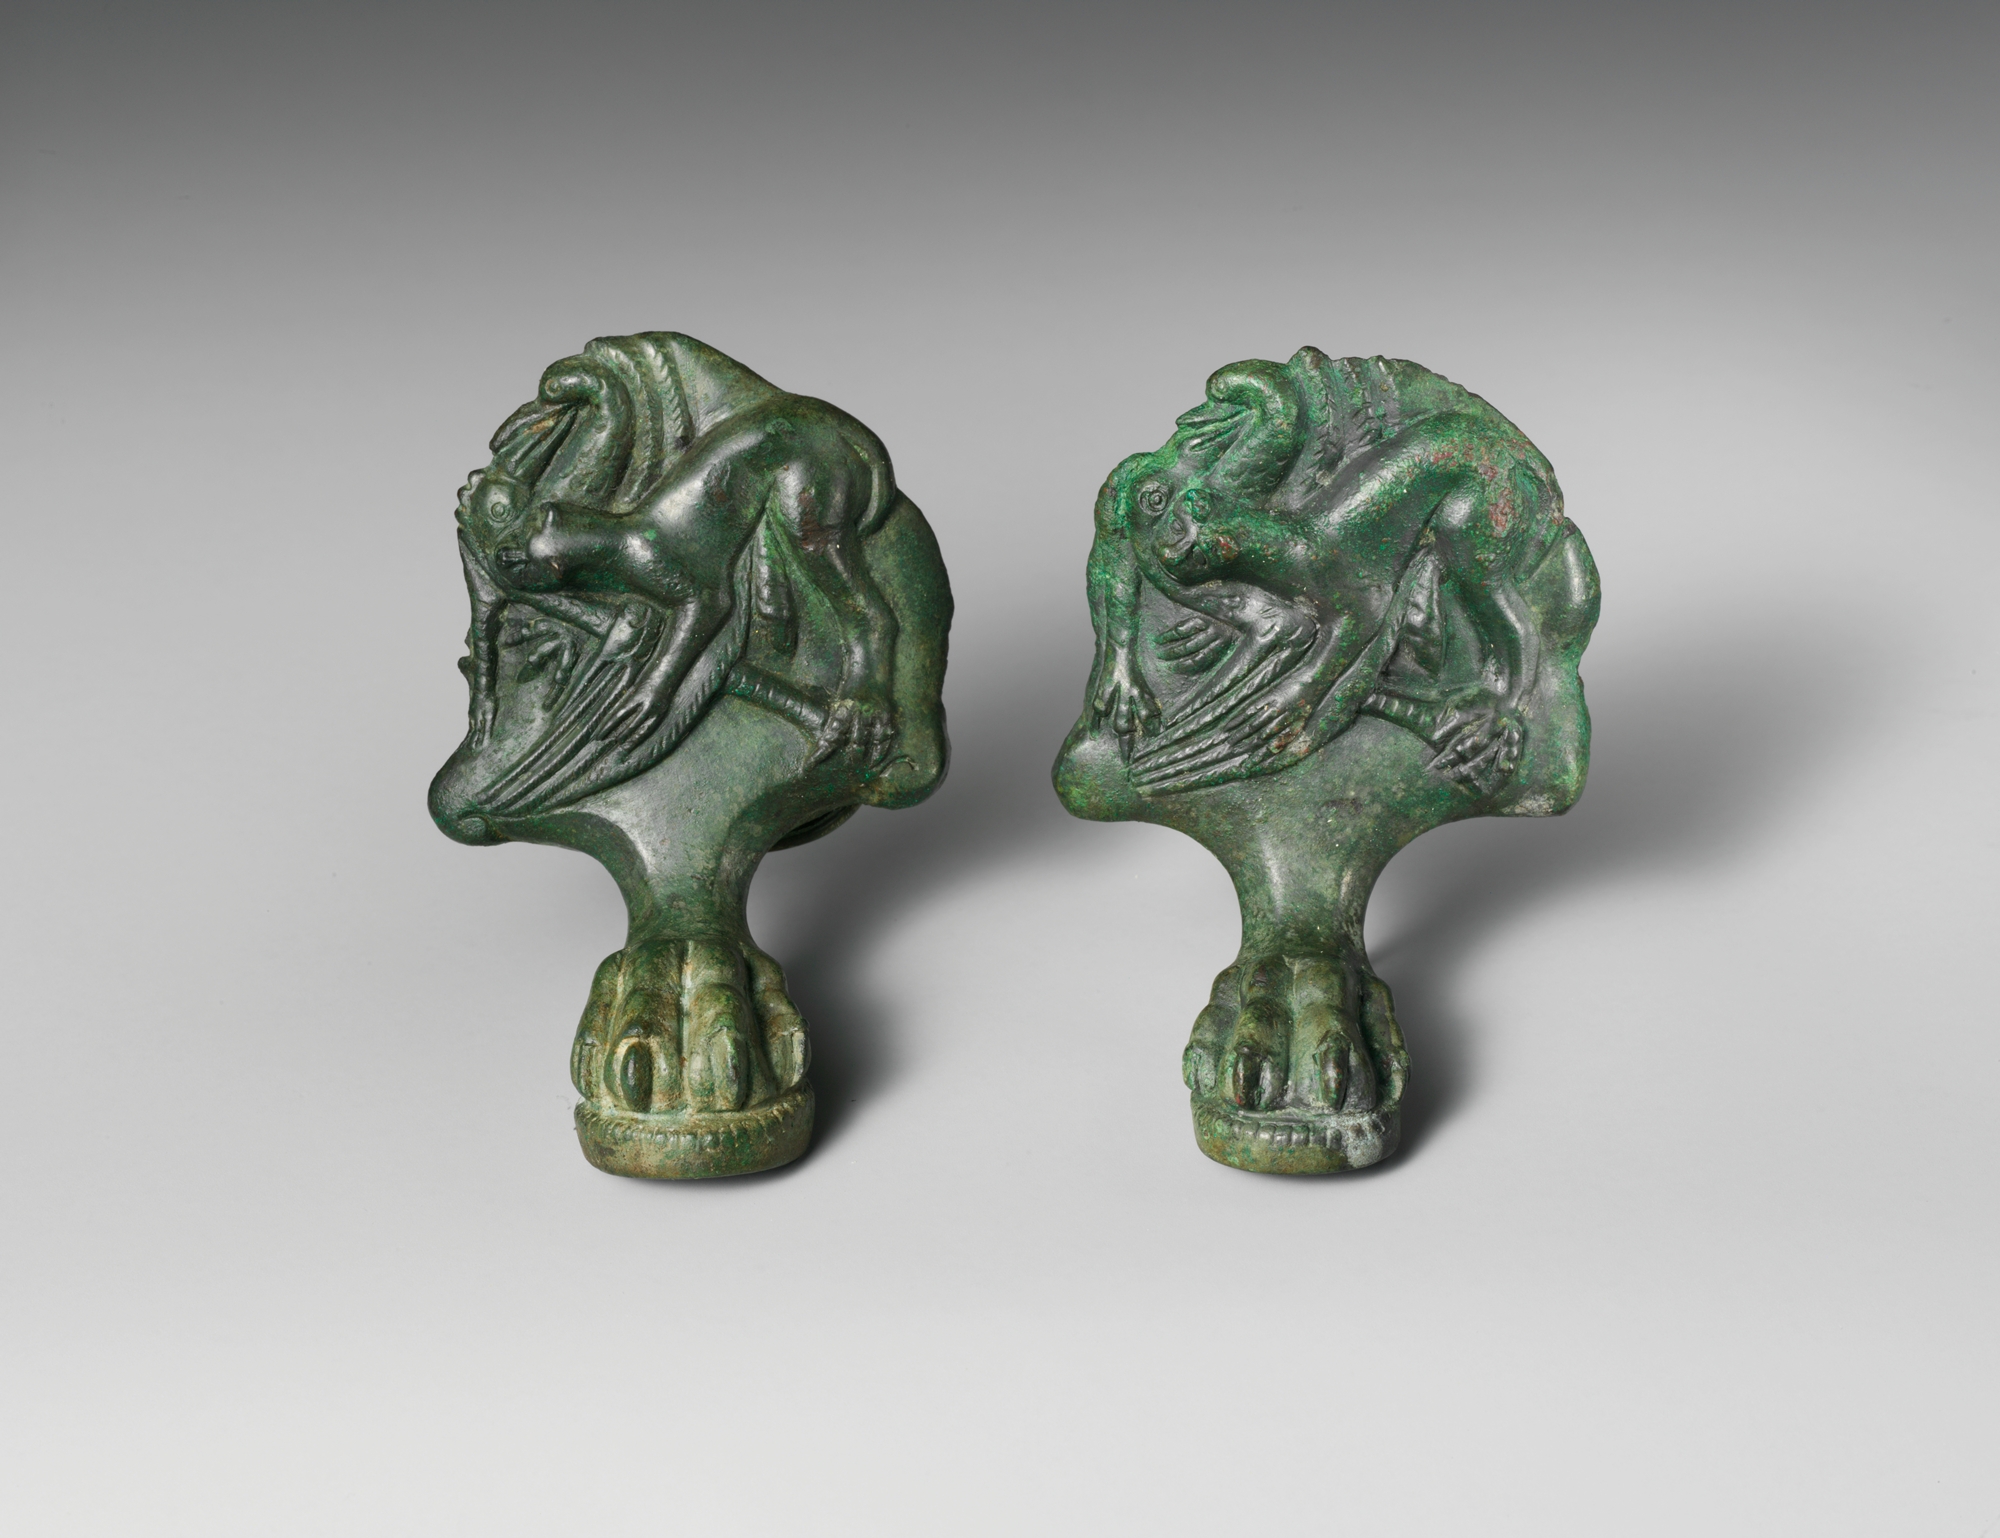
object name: cista, foot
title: Pair of bronze cista (toiletries box) feet with panthers attacking cranes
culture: praenestine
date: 350-300 BCE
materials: bronze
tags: animals,cranes,feet